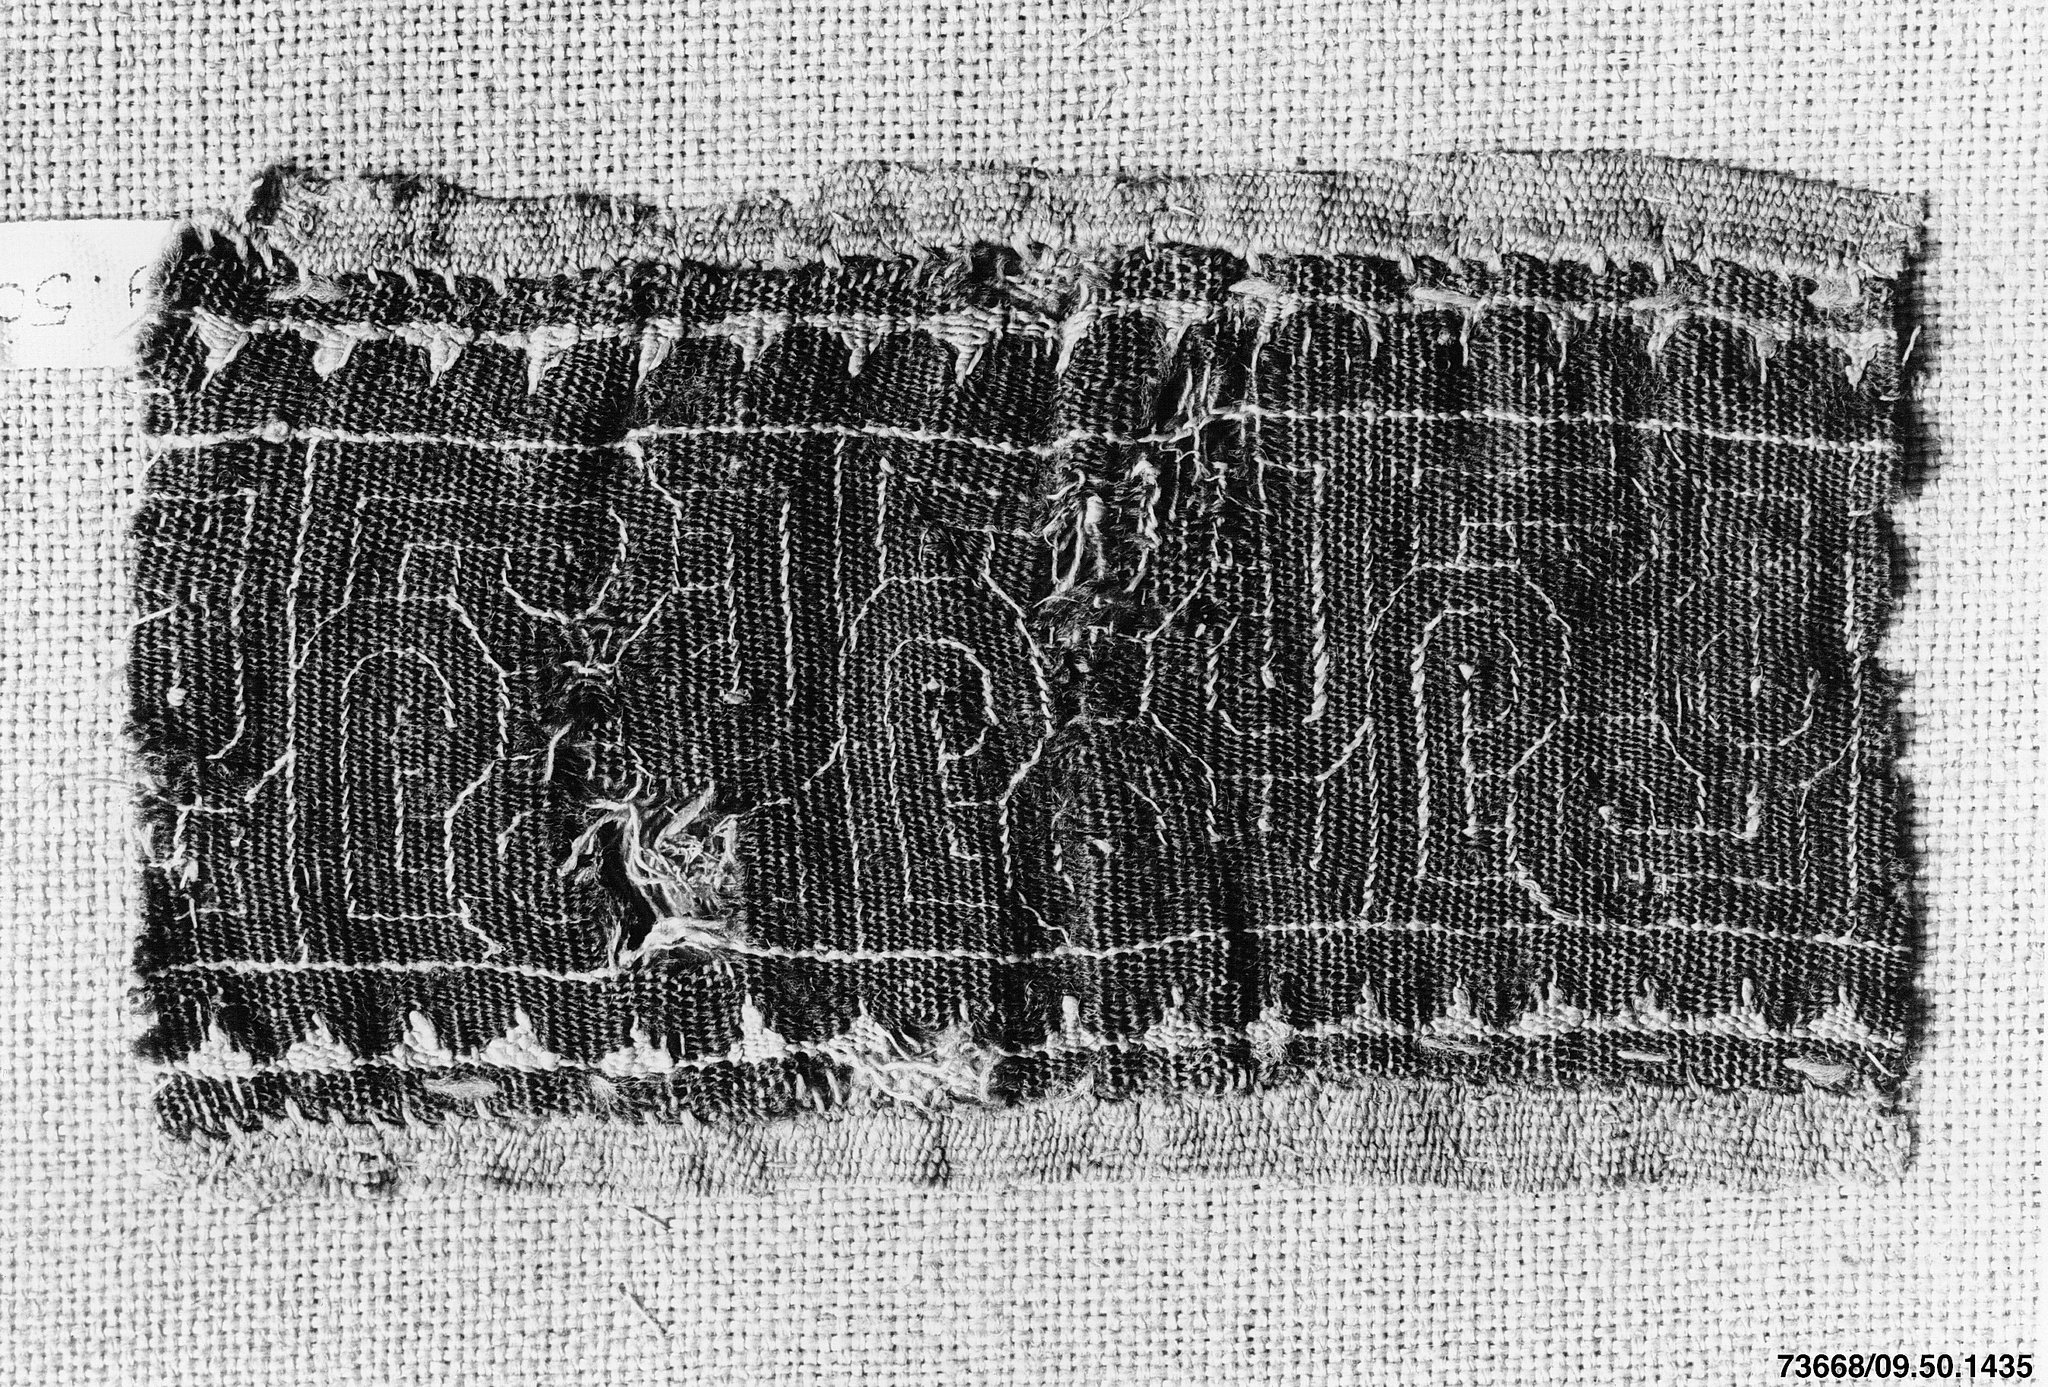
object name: band fragment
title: Fragment of a Band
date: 201-400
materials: linen, wool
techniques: weave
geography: egypt